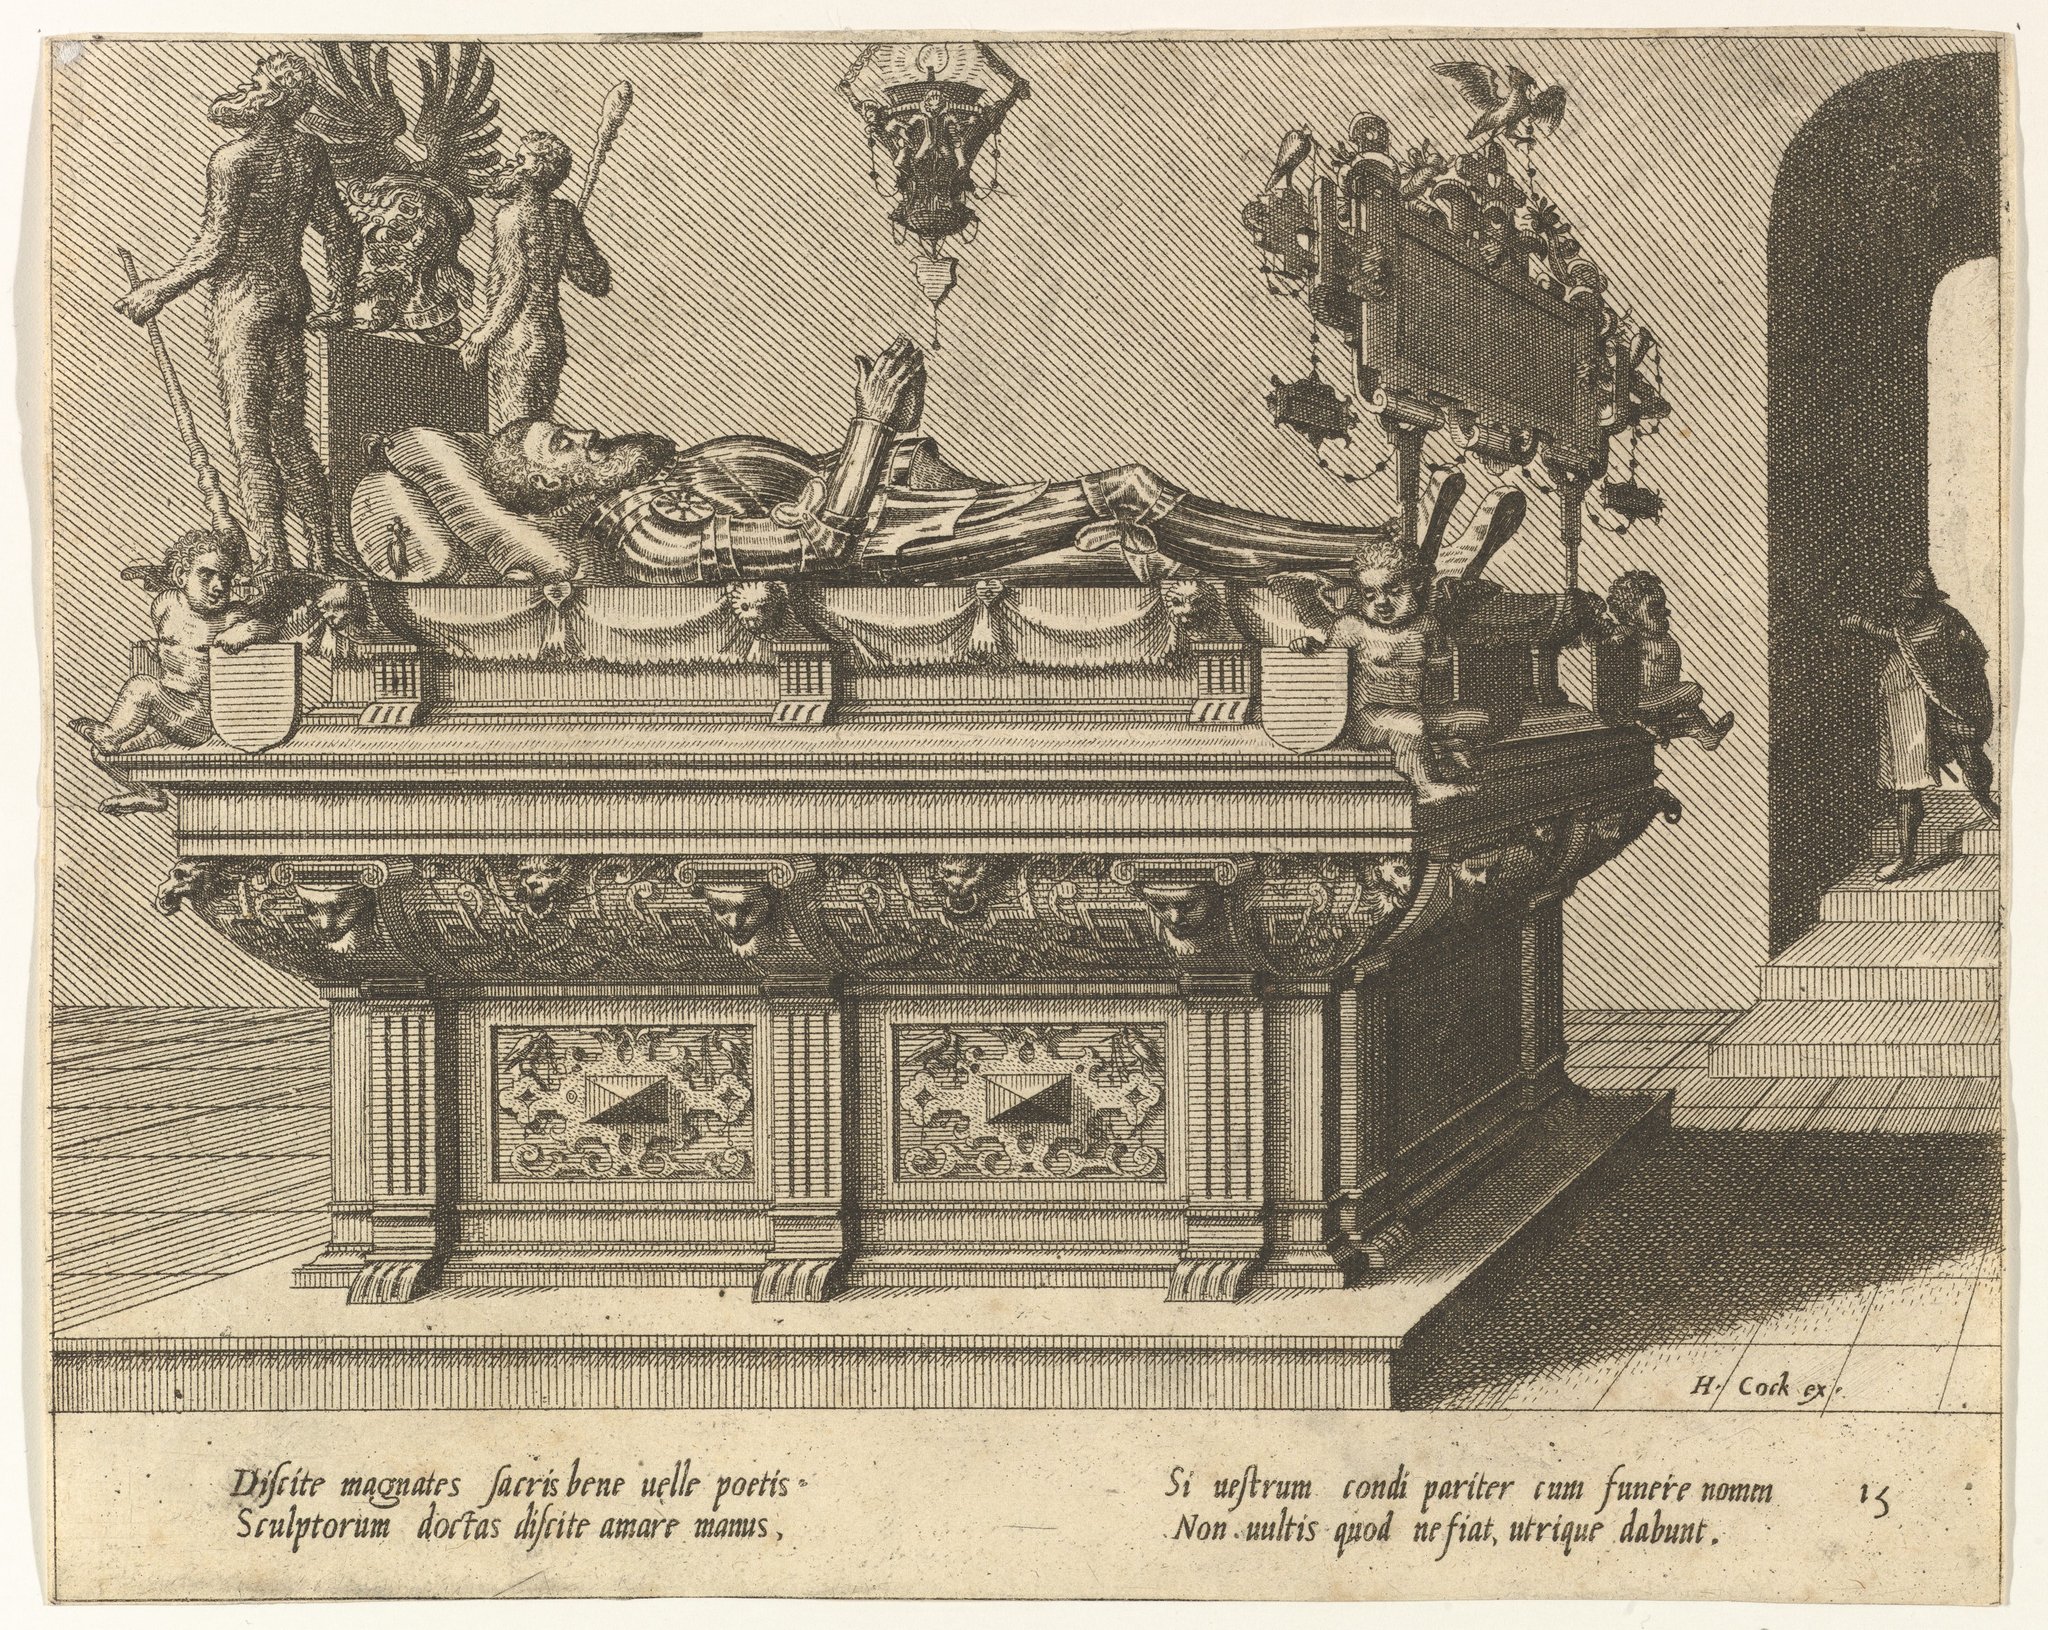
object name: collection ornament architecture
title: Cœnotaphiorum (15)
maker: hans vredeman de vries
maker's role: artist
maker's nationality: netherlandish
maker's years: 1527-1606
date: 1563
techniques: etching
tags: tombs,men